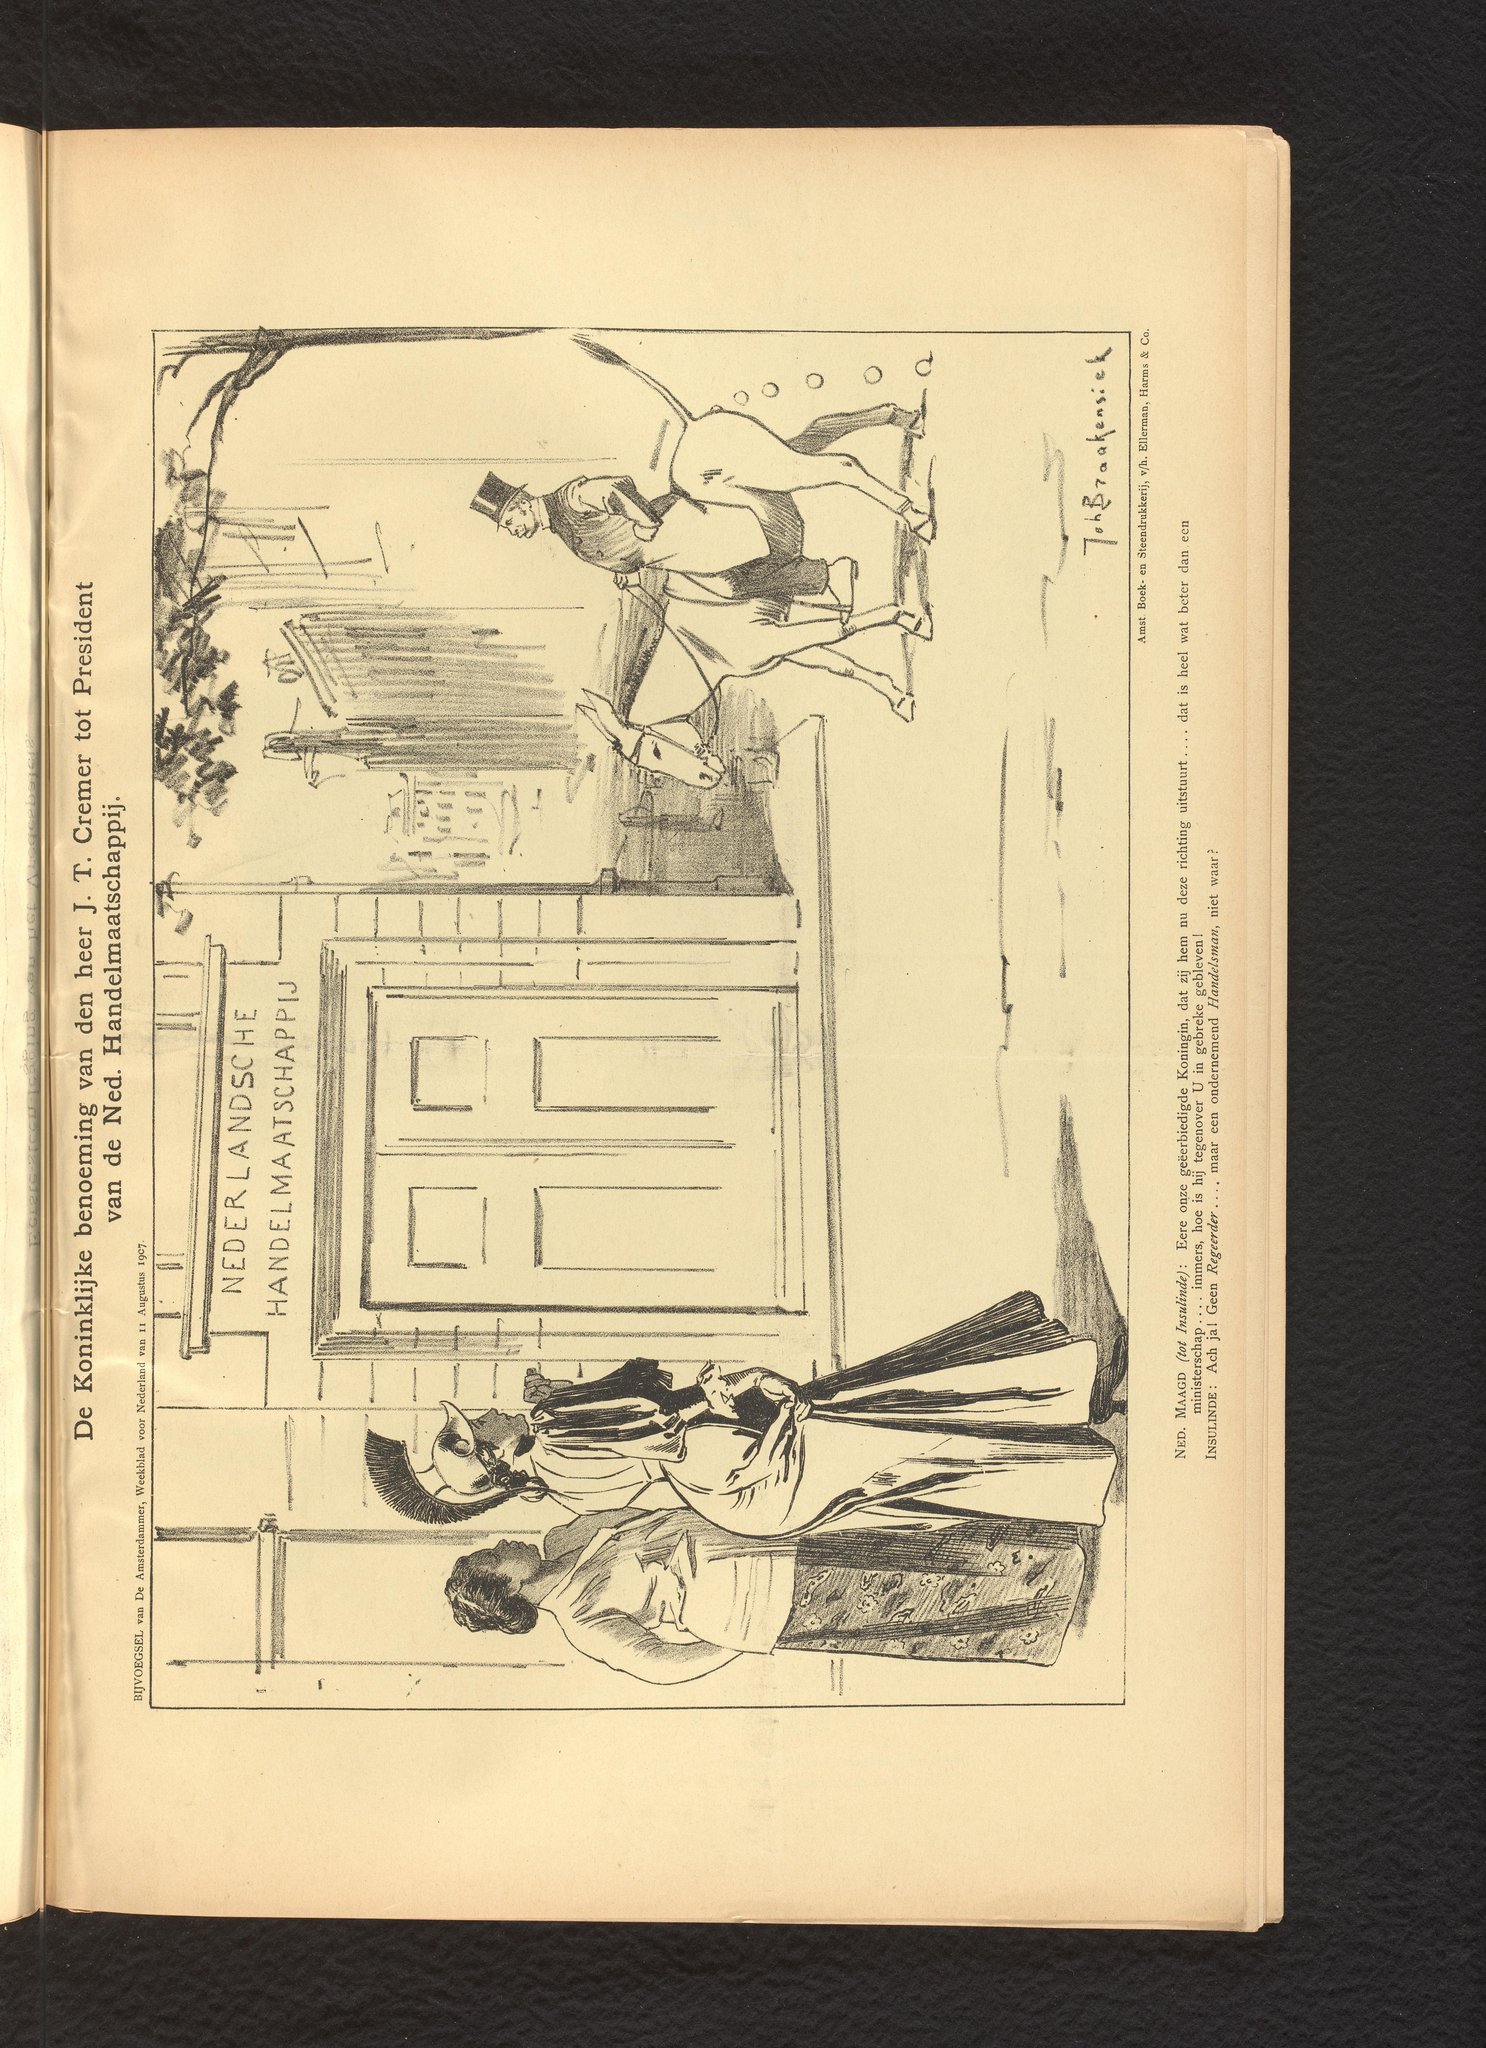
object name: cartoon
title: De Koninklijke benoeming van den heer J.T. Cremer tot President van de Ned. Handelmaatschappij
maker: johan braakensiek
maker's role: draughtsman, print maker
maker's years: 1858-1940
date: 1907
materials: paper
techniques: lithograph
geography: amsterdam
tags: amsterdam, colonial system, riding a horse, ass, or mule; rider, horseman, personifications of countries, nations, states, districts, etc., tales and fairy tales, political caricatures and satires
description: De Nederlandse Maagd en Insulinde (de kolonie Nederlands-Indië) zien de aankomst van Jacob Theodoor Cremer bij de Nederlandsche Handel-Maatschappij, rijdend op een ezel die gouden munten poept (Tafeltje Dek Je, Ezeltje Strek Je) uit het sprookje van Grimm.